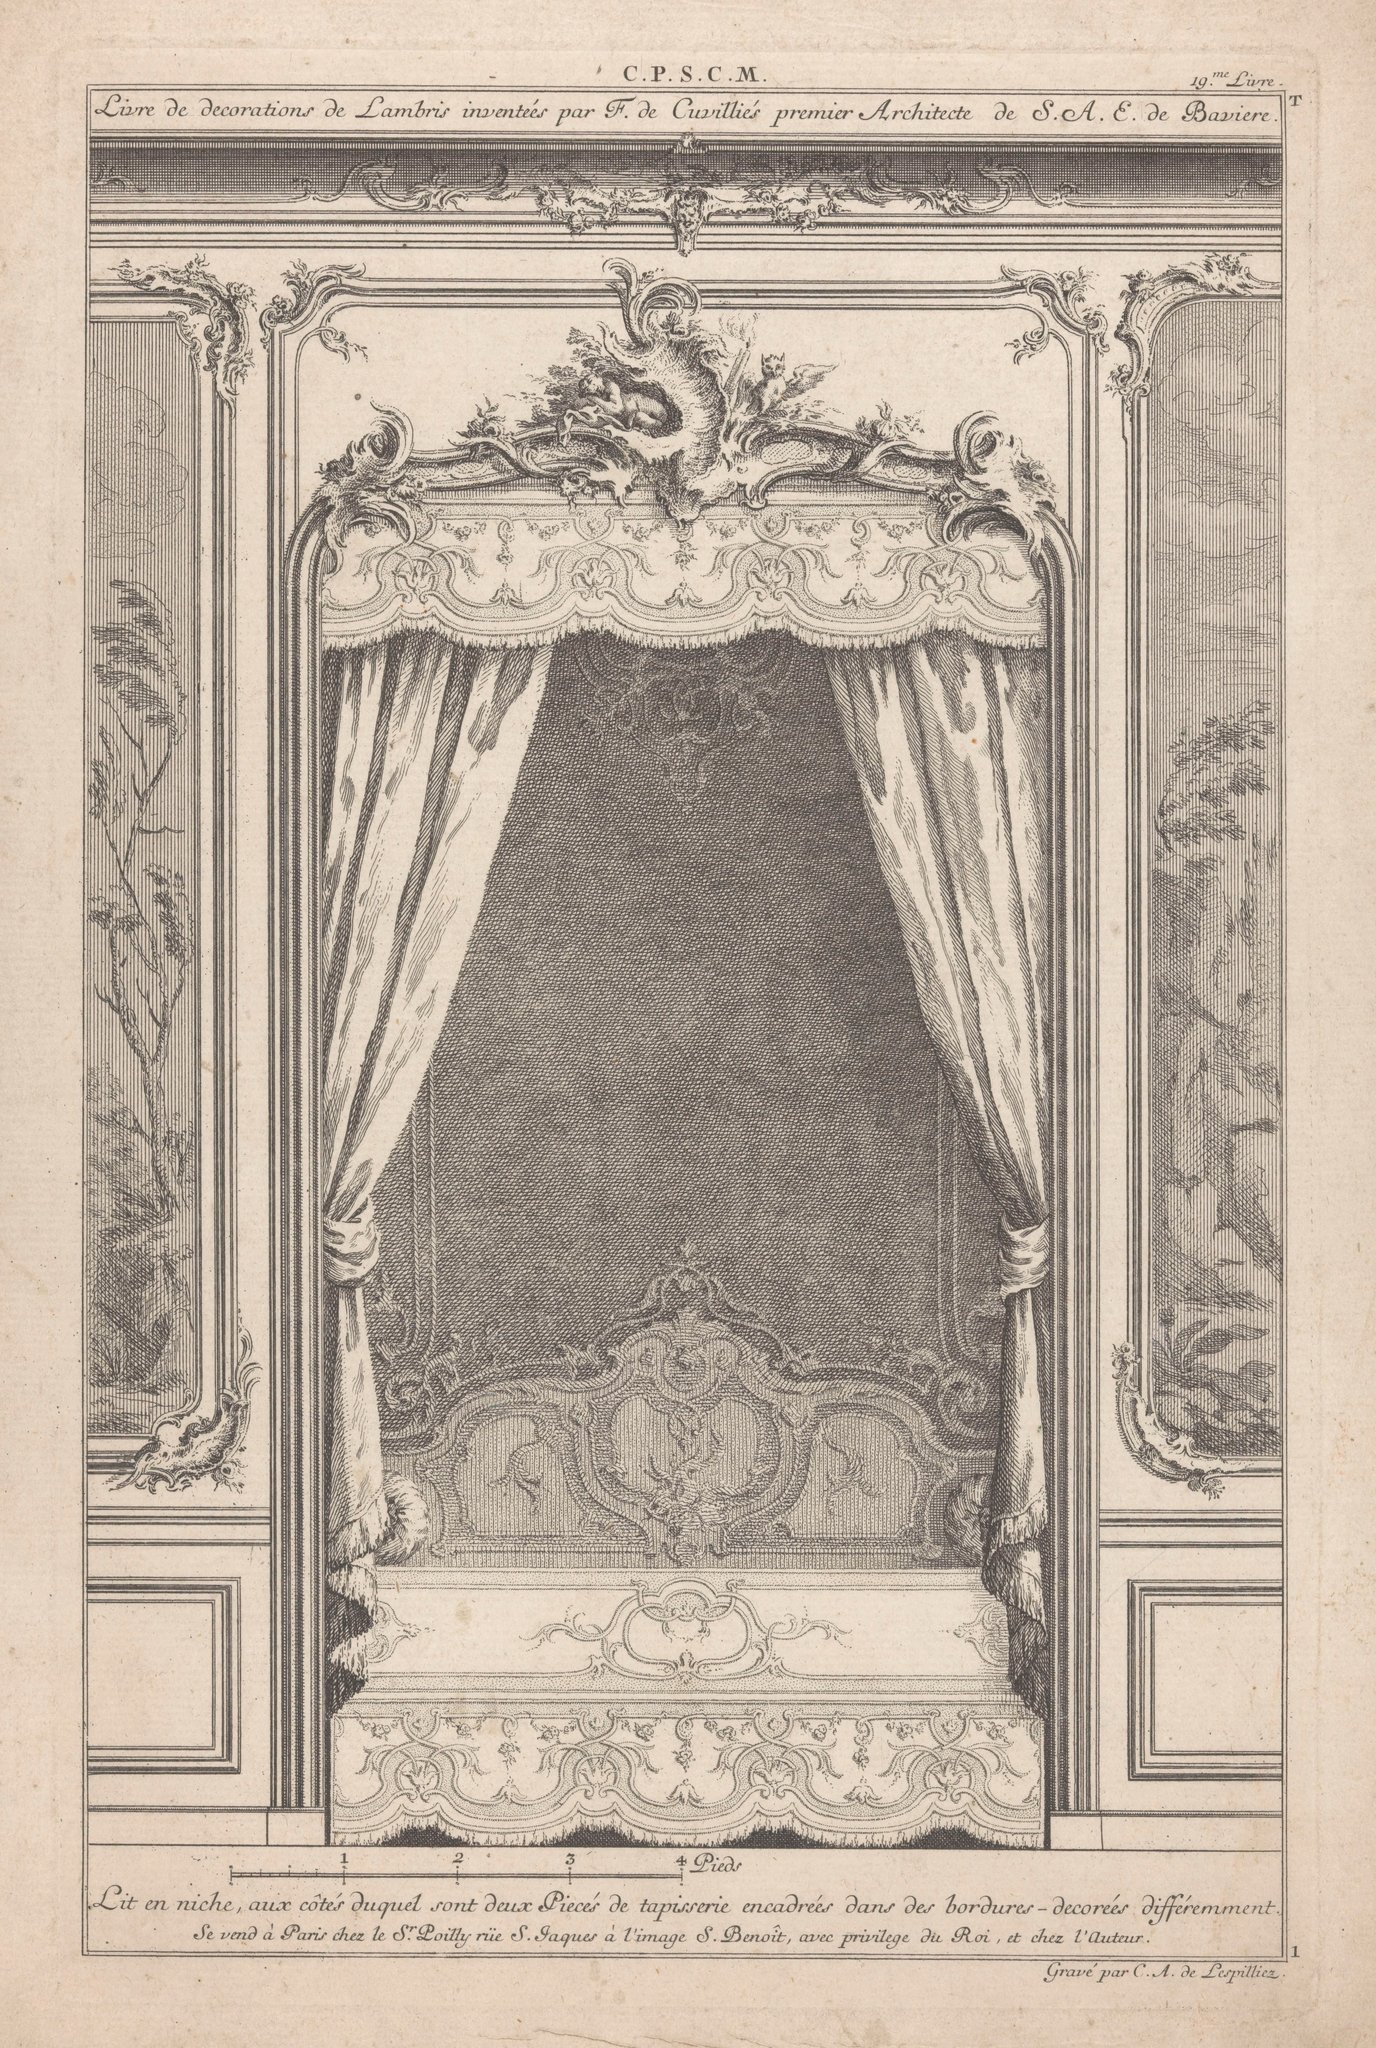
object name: ornament print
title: 19me Livre T Livre de decorations de Lambris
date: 1745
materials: paper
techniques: engraving, etching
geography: germany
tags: built-in bedstead (dutch: 'bedstee')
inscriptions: collector's mark: Lugt 2228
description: Een geornamenteerd bed in een nis met draperieën, aan weerszijden panelen met landschappen.